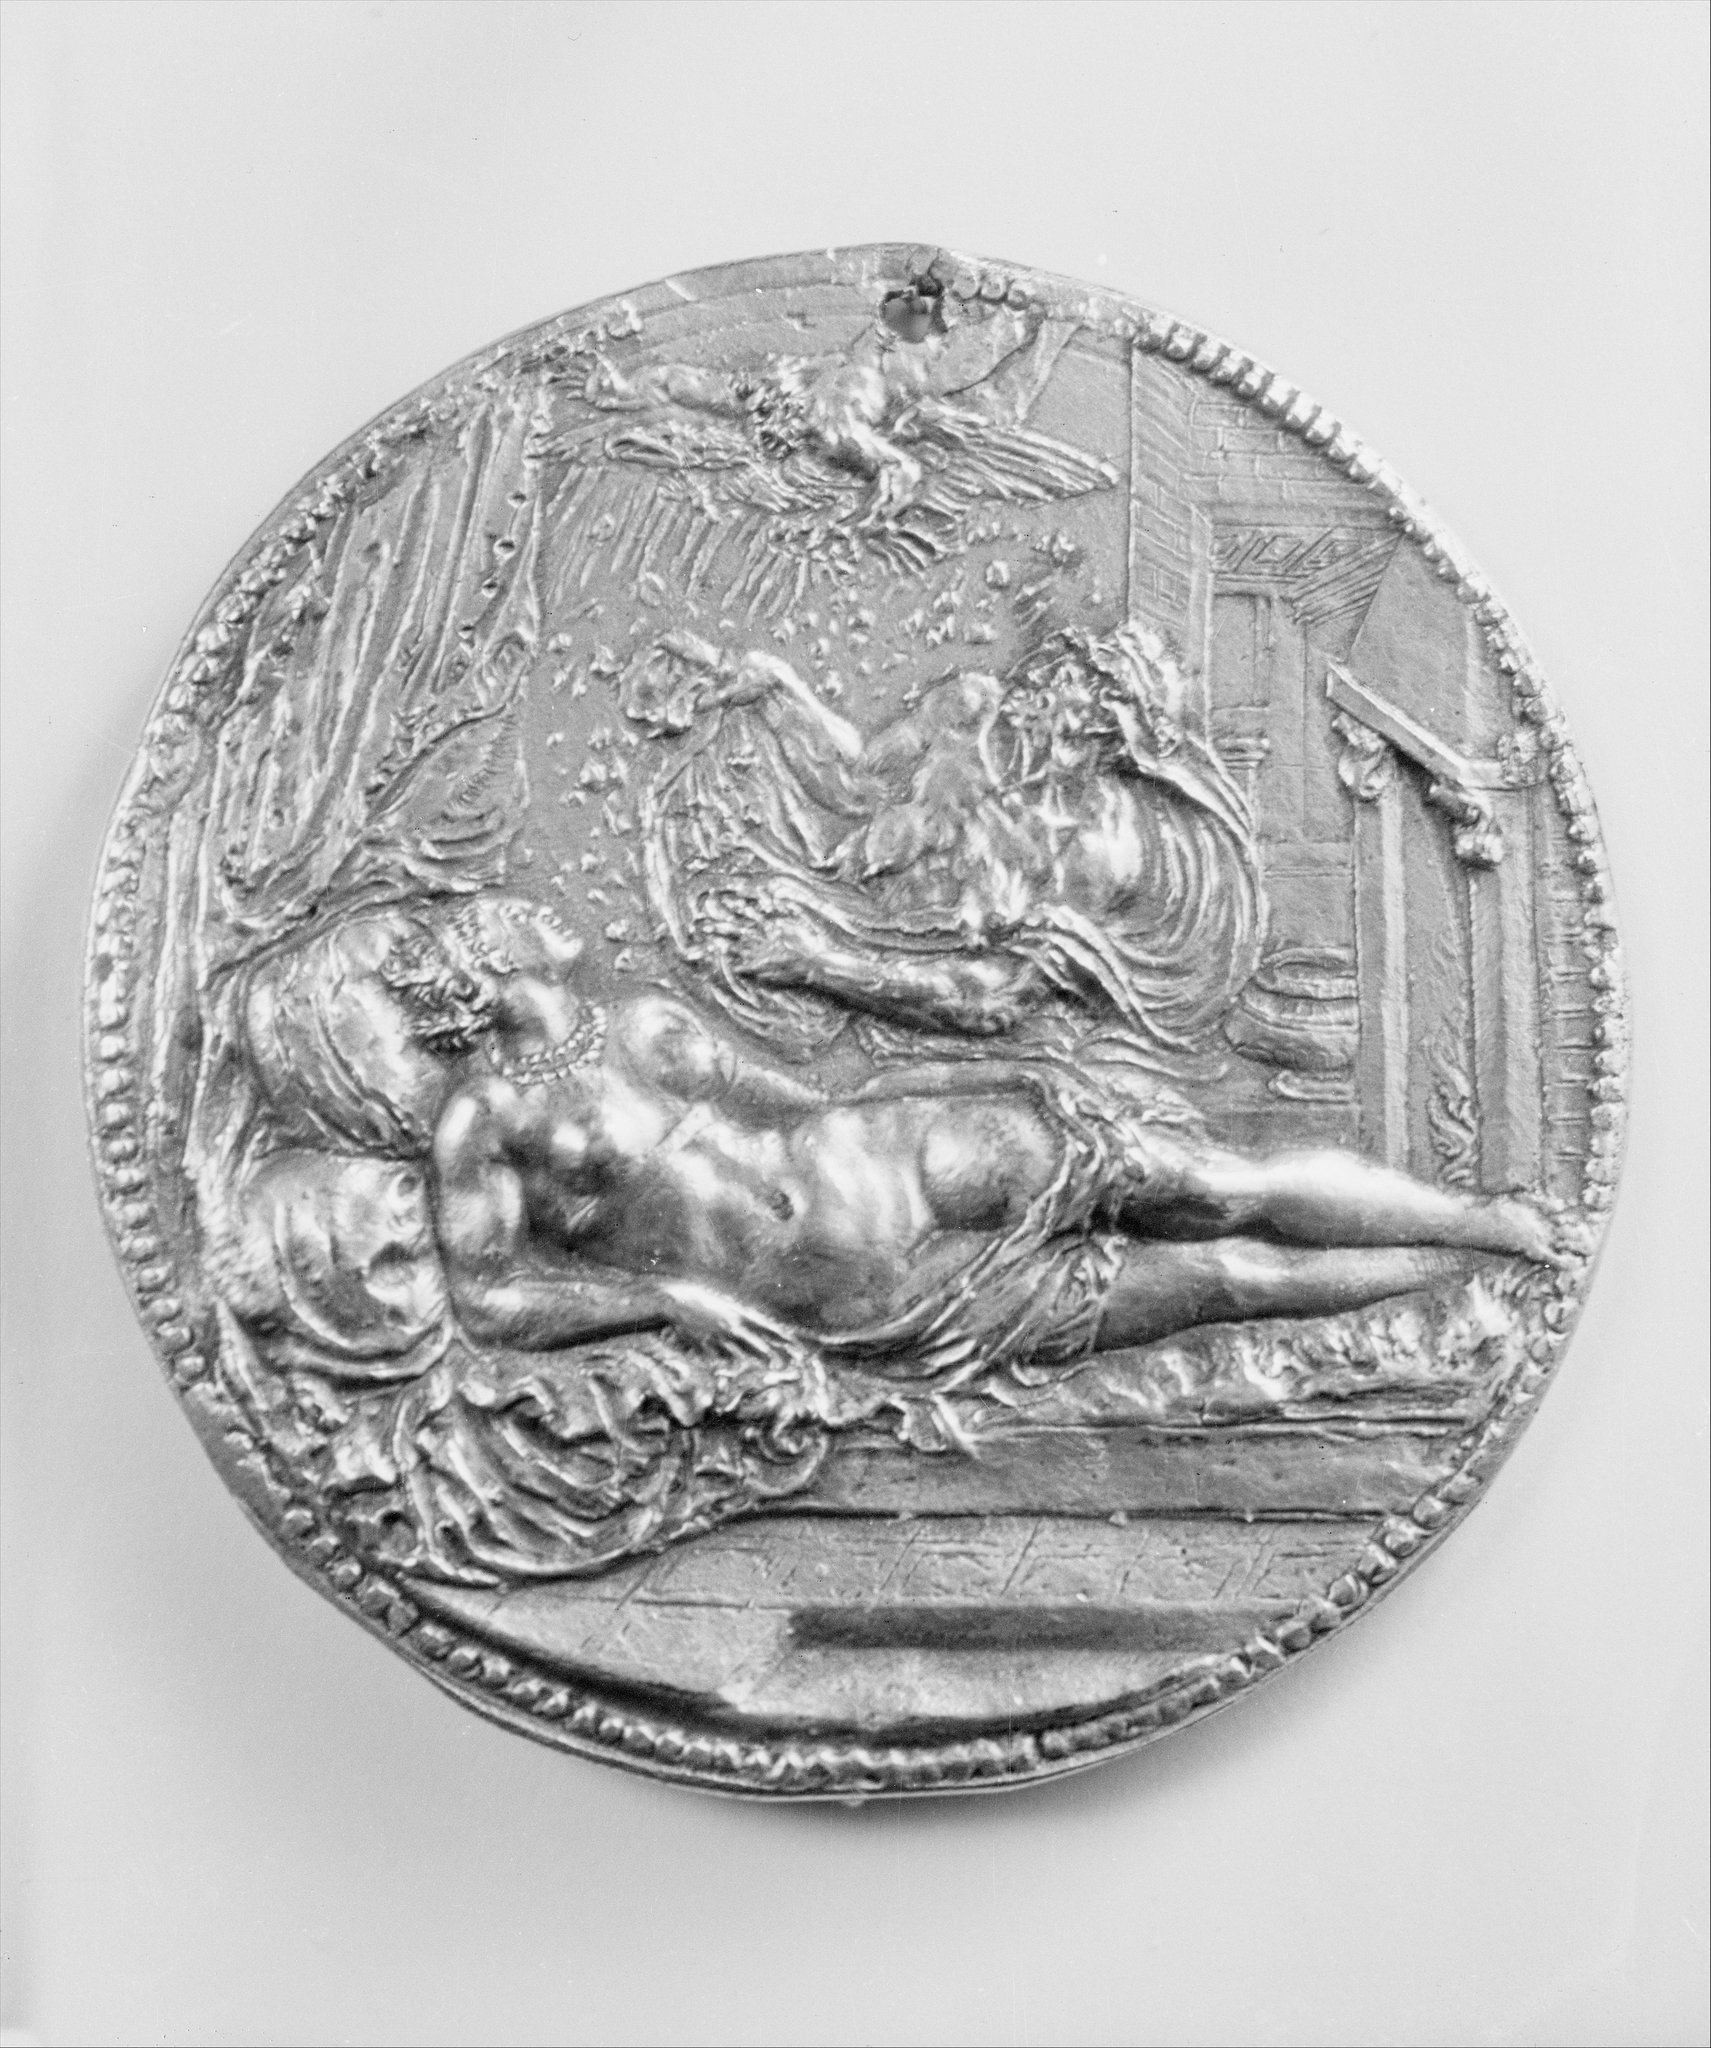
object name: plaquette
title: Danae and the Shower of Gold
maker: pompeo leoni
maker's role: maker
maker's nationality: italian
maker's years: 1533-1608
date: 1550-1575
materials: gilt bronze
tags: eagles,women